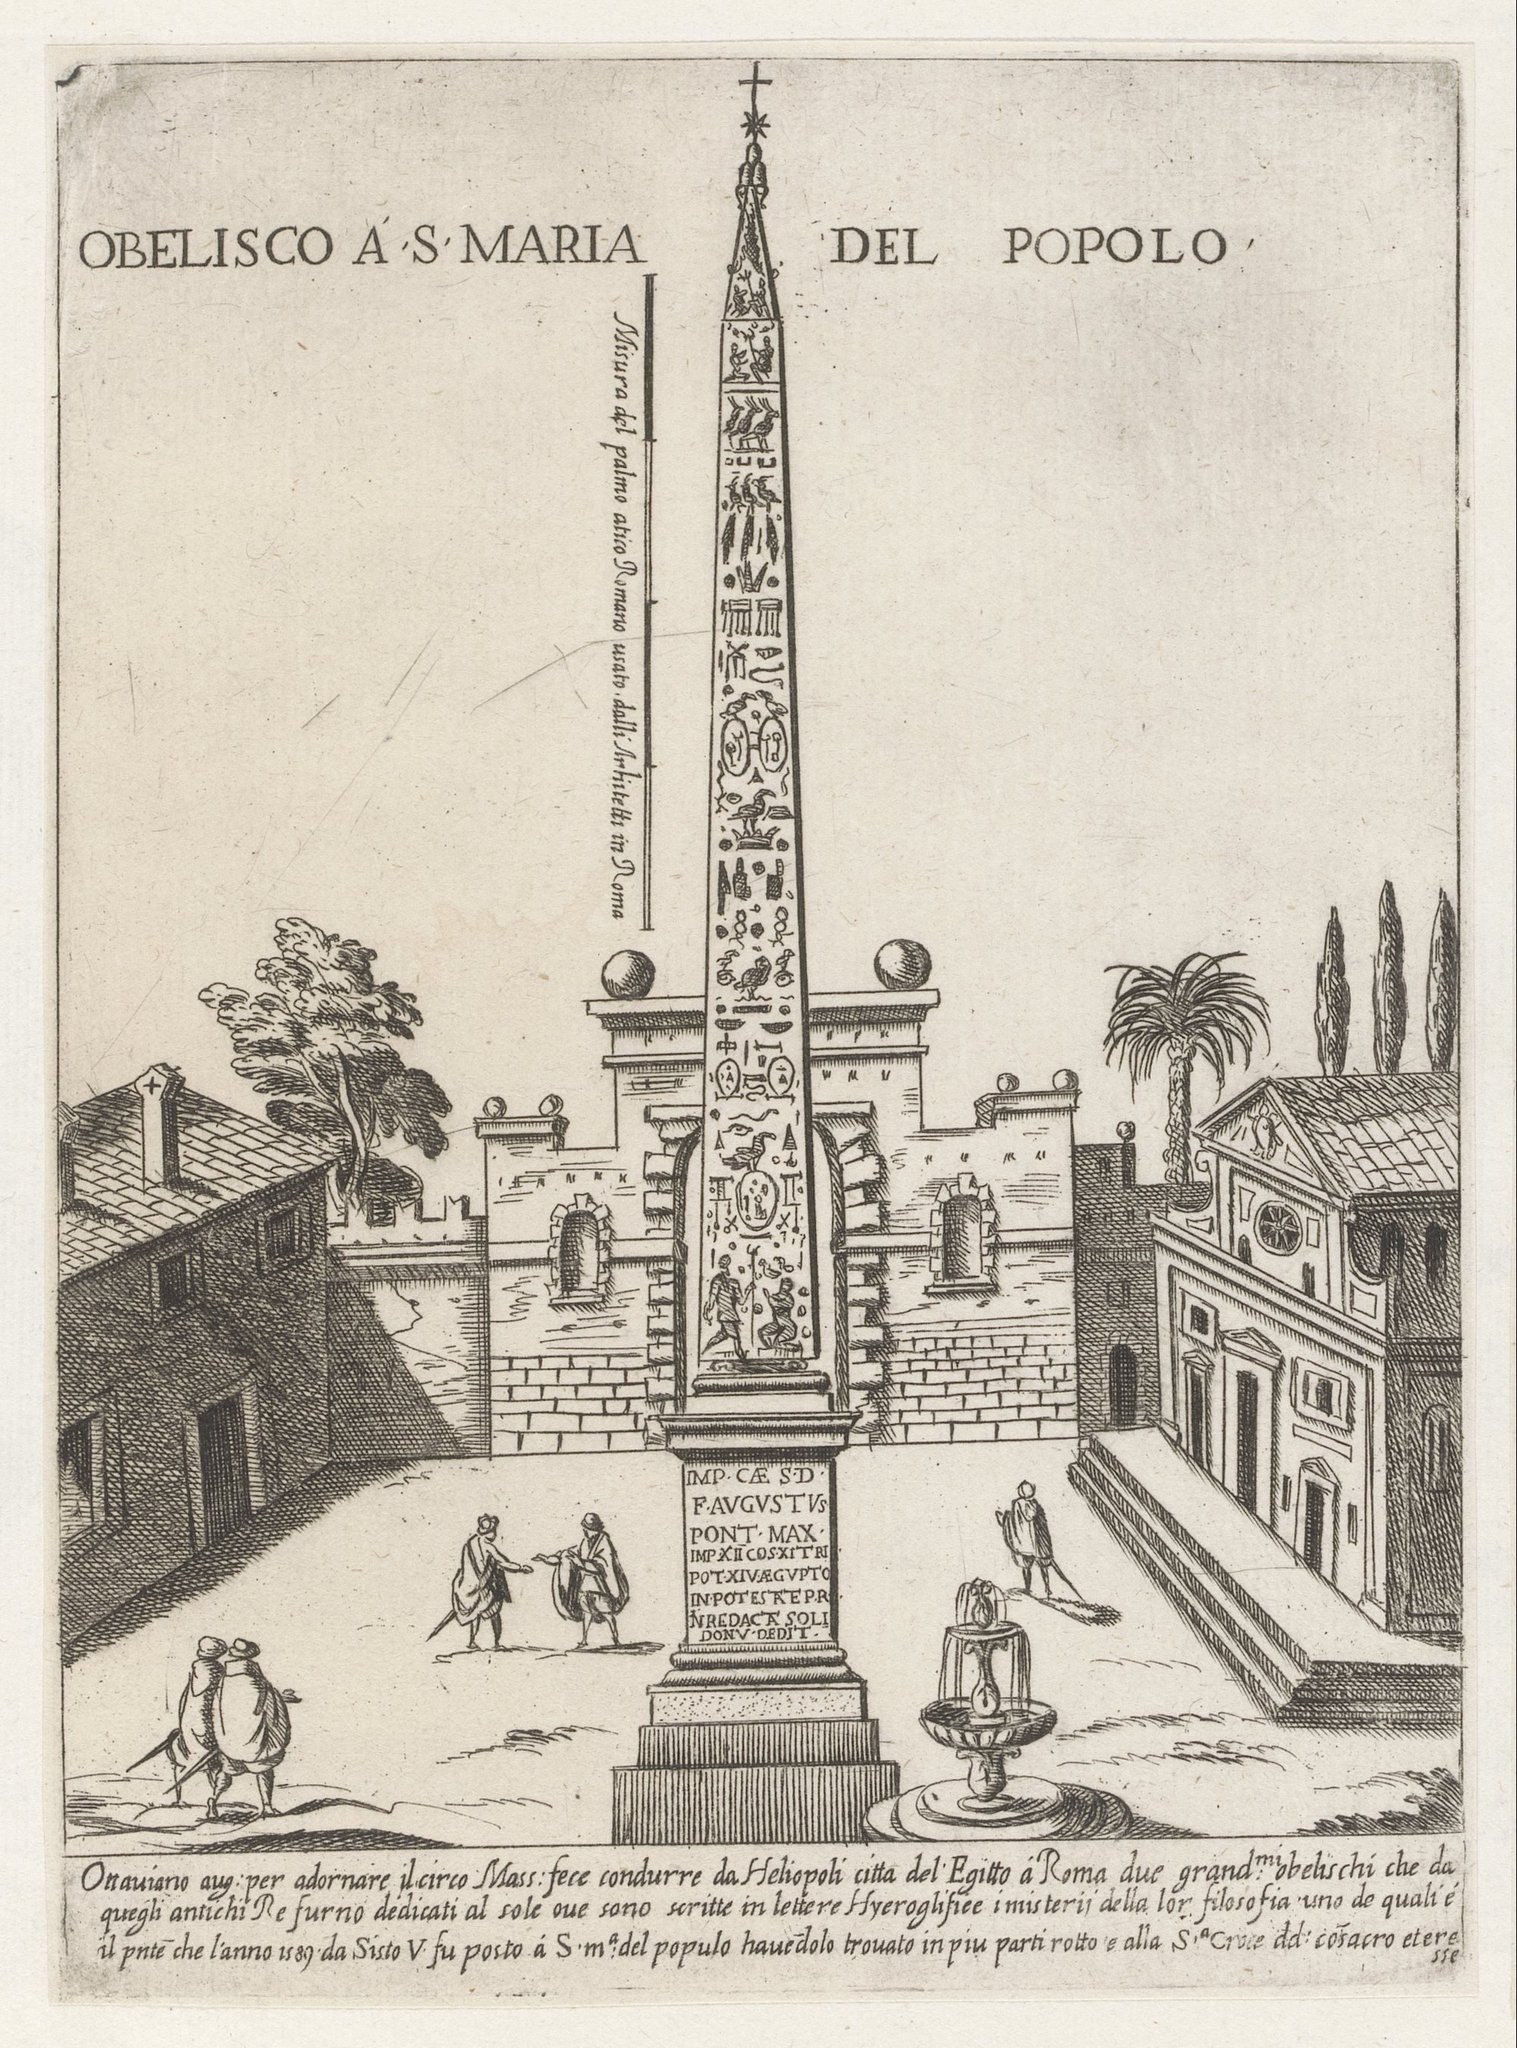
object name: album leaf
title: Magesyn der Italiaense gebouwen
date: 1651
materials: paper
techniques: etching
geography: rome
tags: square, place, circus, etc., obelisk, needle, church (exterior), city-gate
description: Deze prent maakt deel uit van een set prenten (+ titelprent) van zuilen en obelisken in Rome door Giovanni Maggi die is aangevuld met prenten door Louis Rouhier.